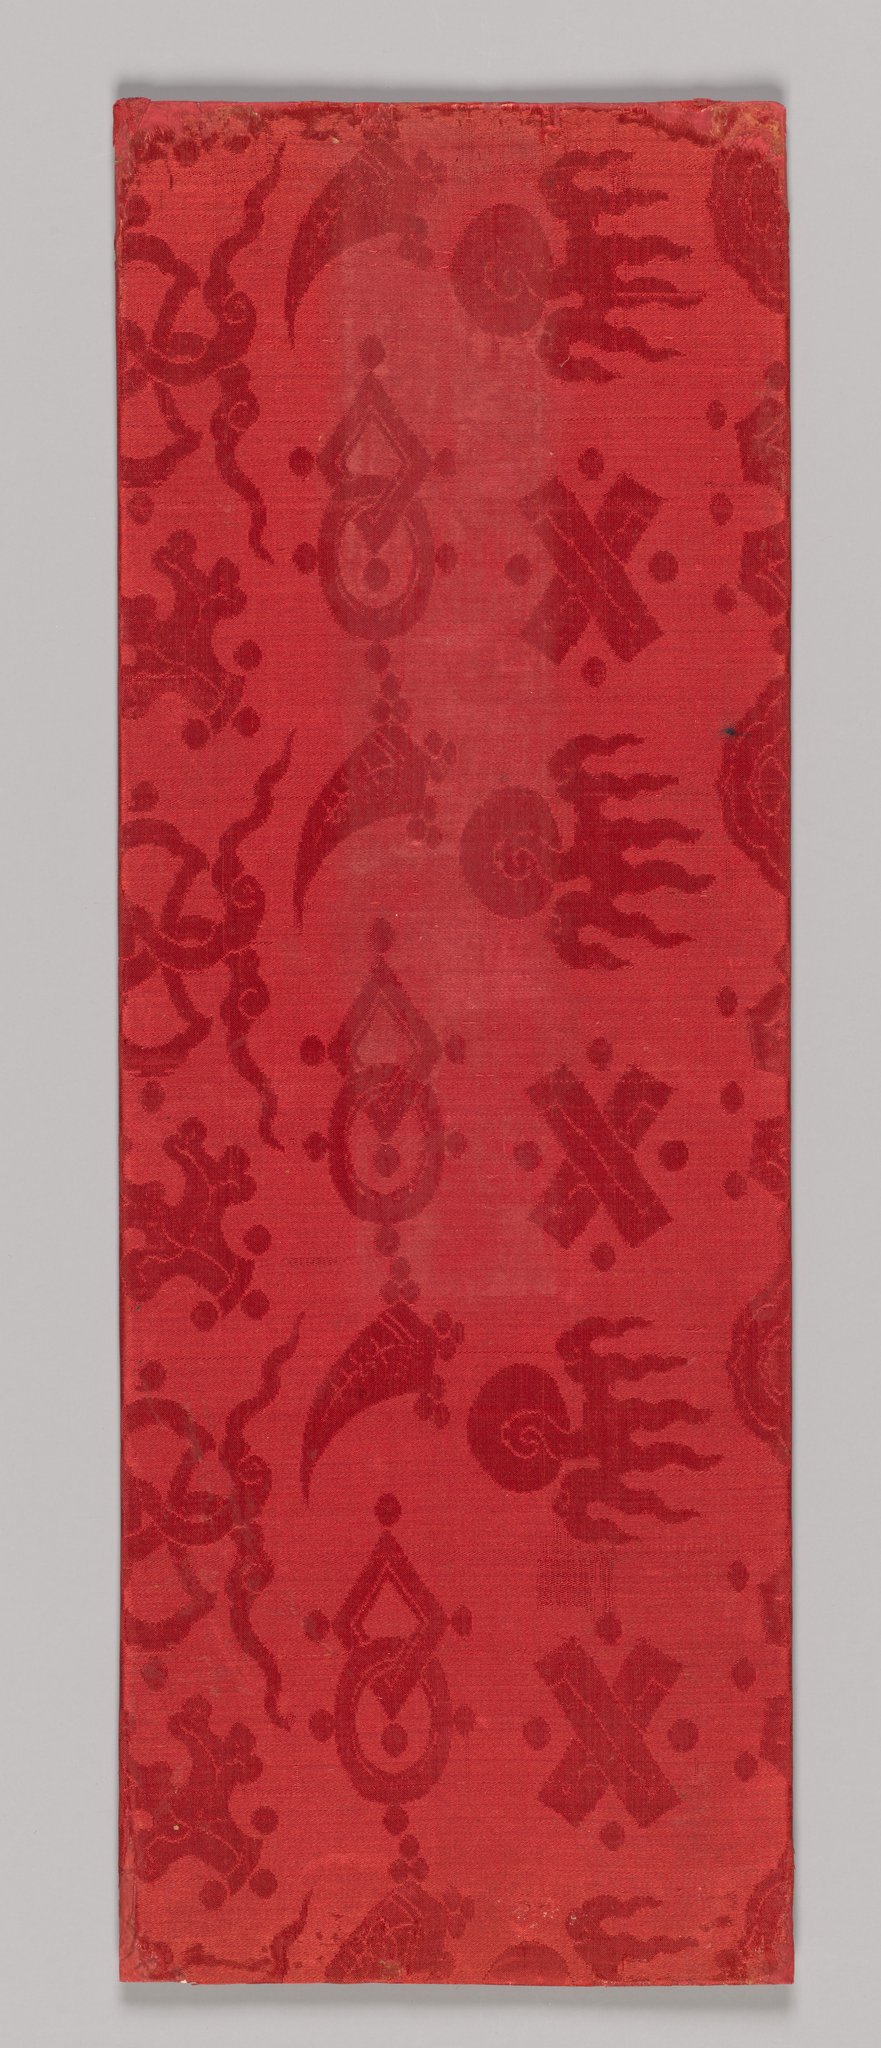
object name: sutra cover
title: Sutra Cover with Auspicious Symbols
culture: chinese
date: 1501-1600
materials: silk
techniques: damask